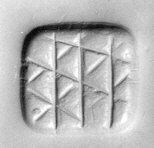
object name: stamp seal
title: Loop-handled rectangular seal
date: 6000-4001 BCE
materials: mineral, stone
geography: northern syria or northern mesopotamia